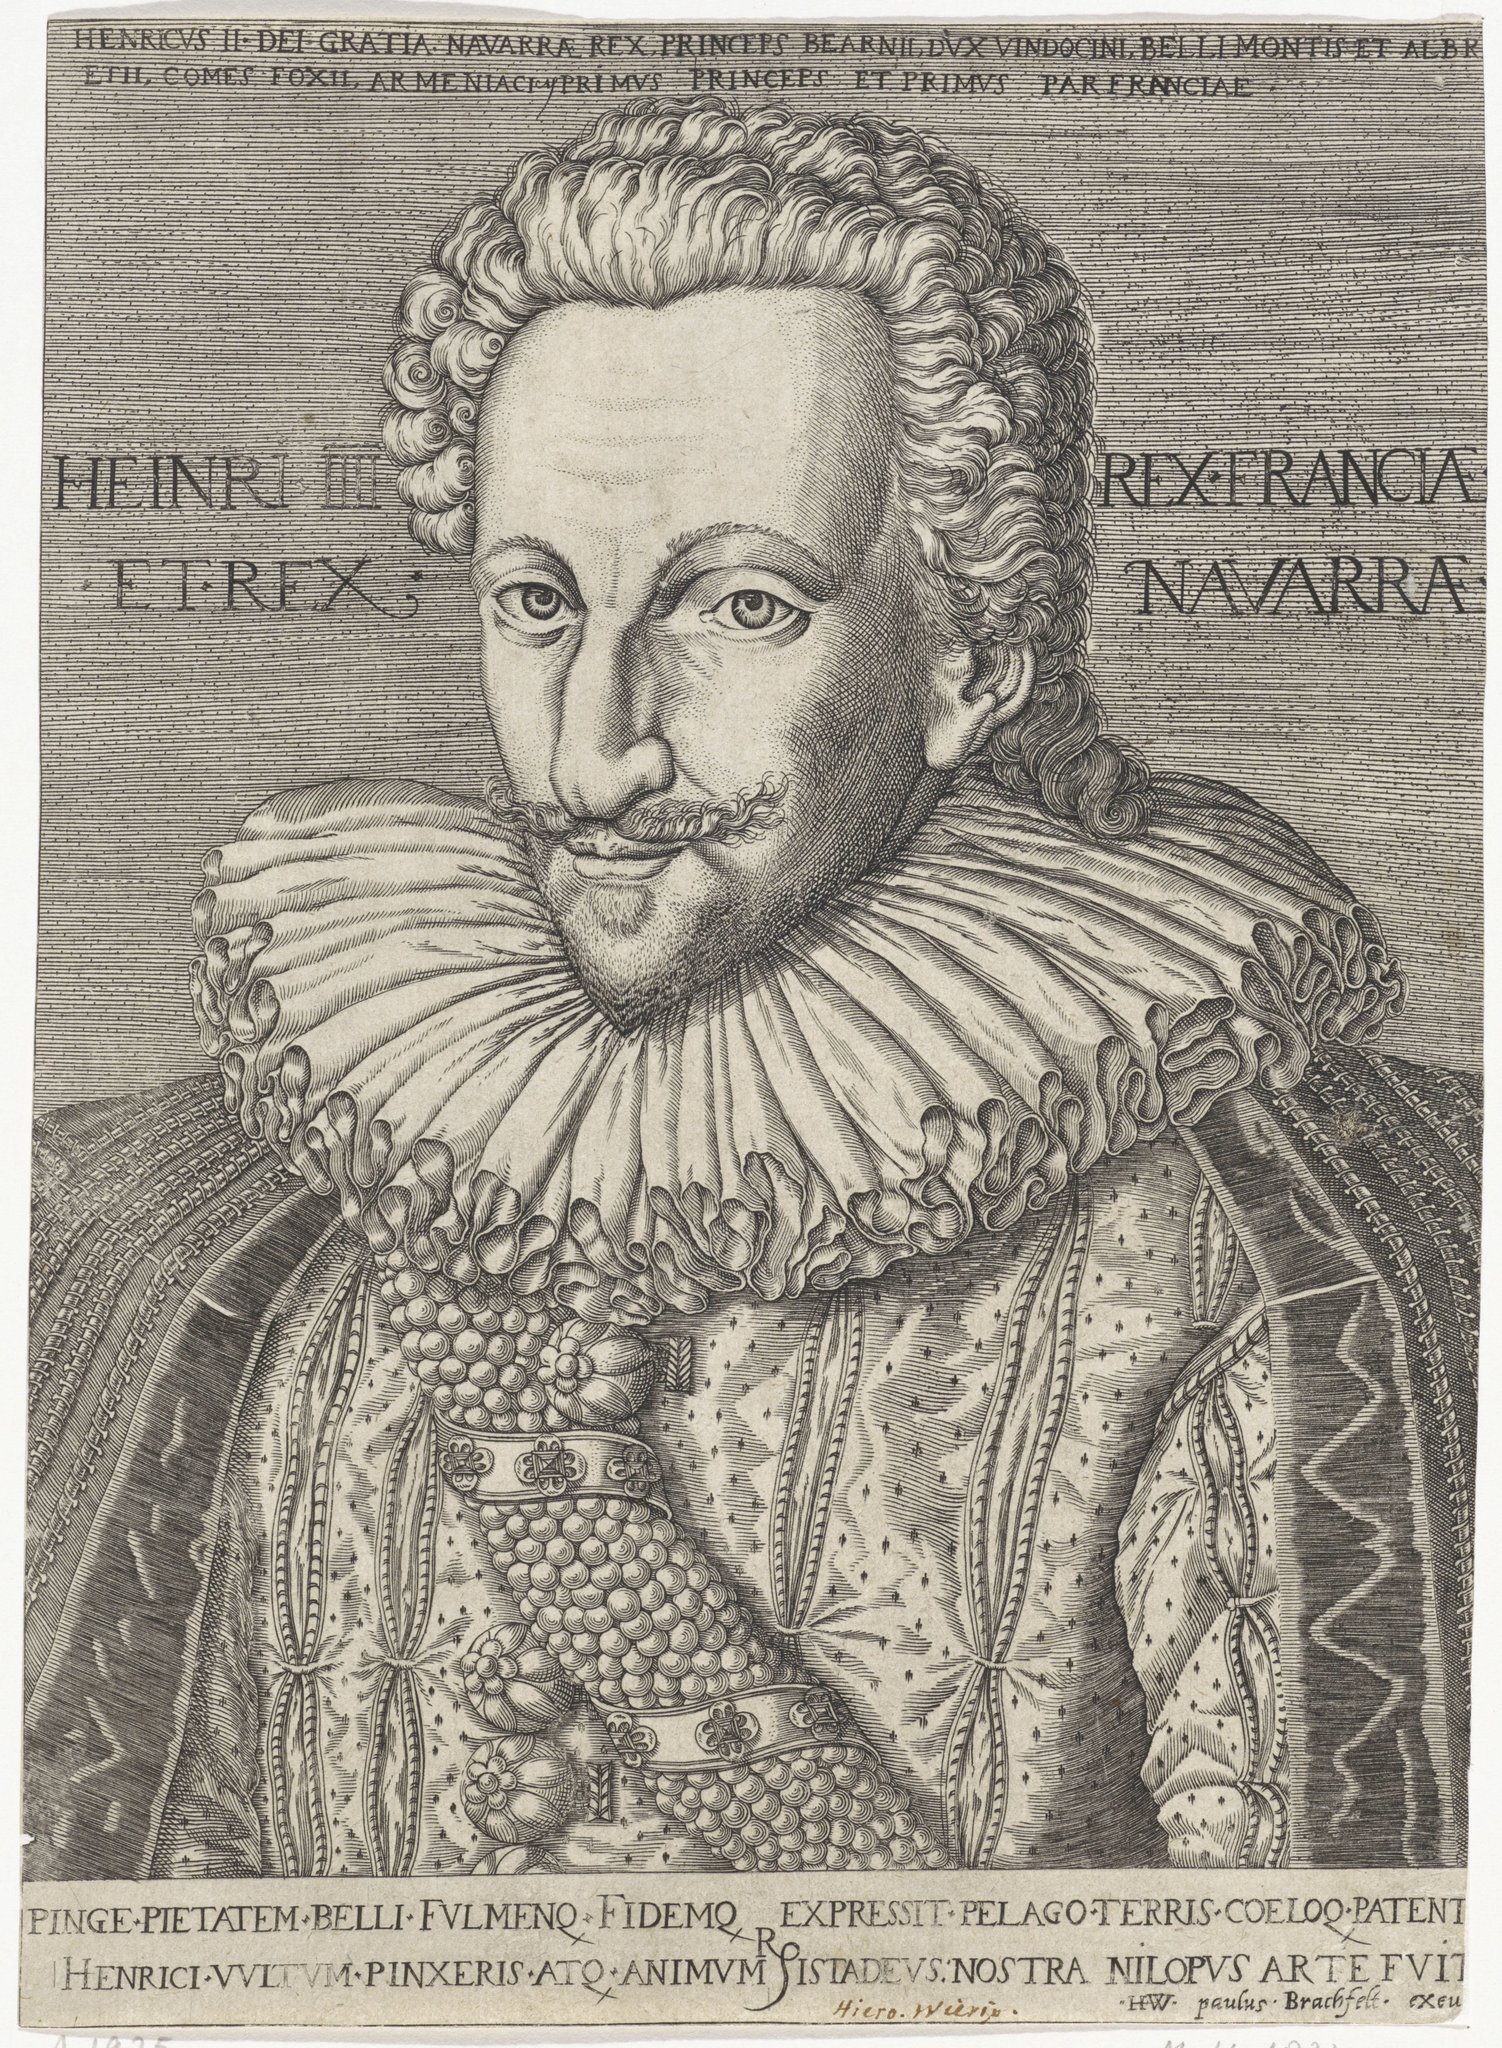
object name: print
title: Portret van Hendrik IV, koning van Frankrijk en Navarra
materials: paper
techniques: engraving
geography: germany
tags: hendrik iv (koning van frankrijk en navarra)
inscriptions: inscription: ‘Hiero. Wierix’, collector's mark: Lugt 2228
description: De prent heeft een tweeregelig bovenschrift in het Latijn. In de marge een tweeregelig onderschrift in het Latijn.